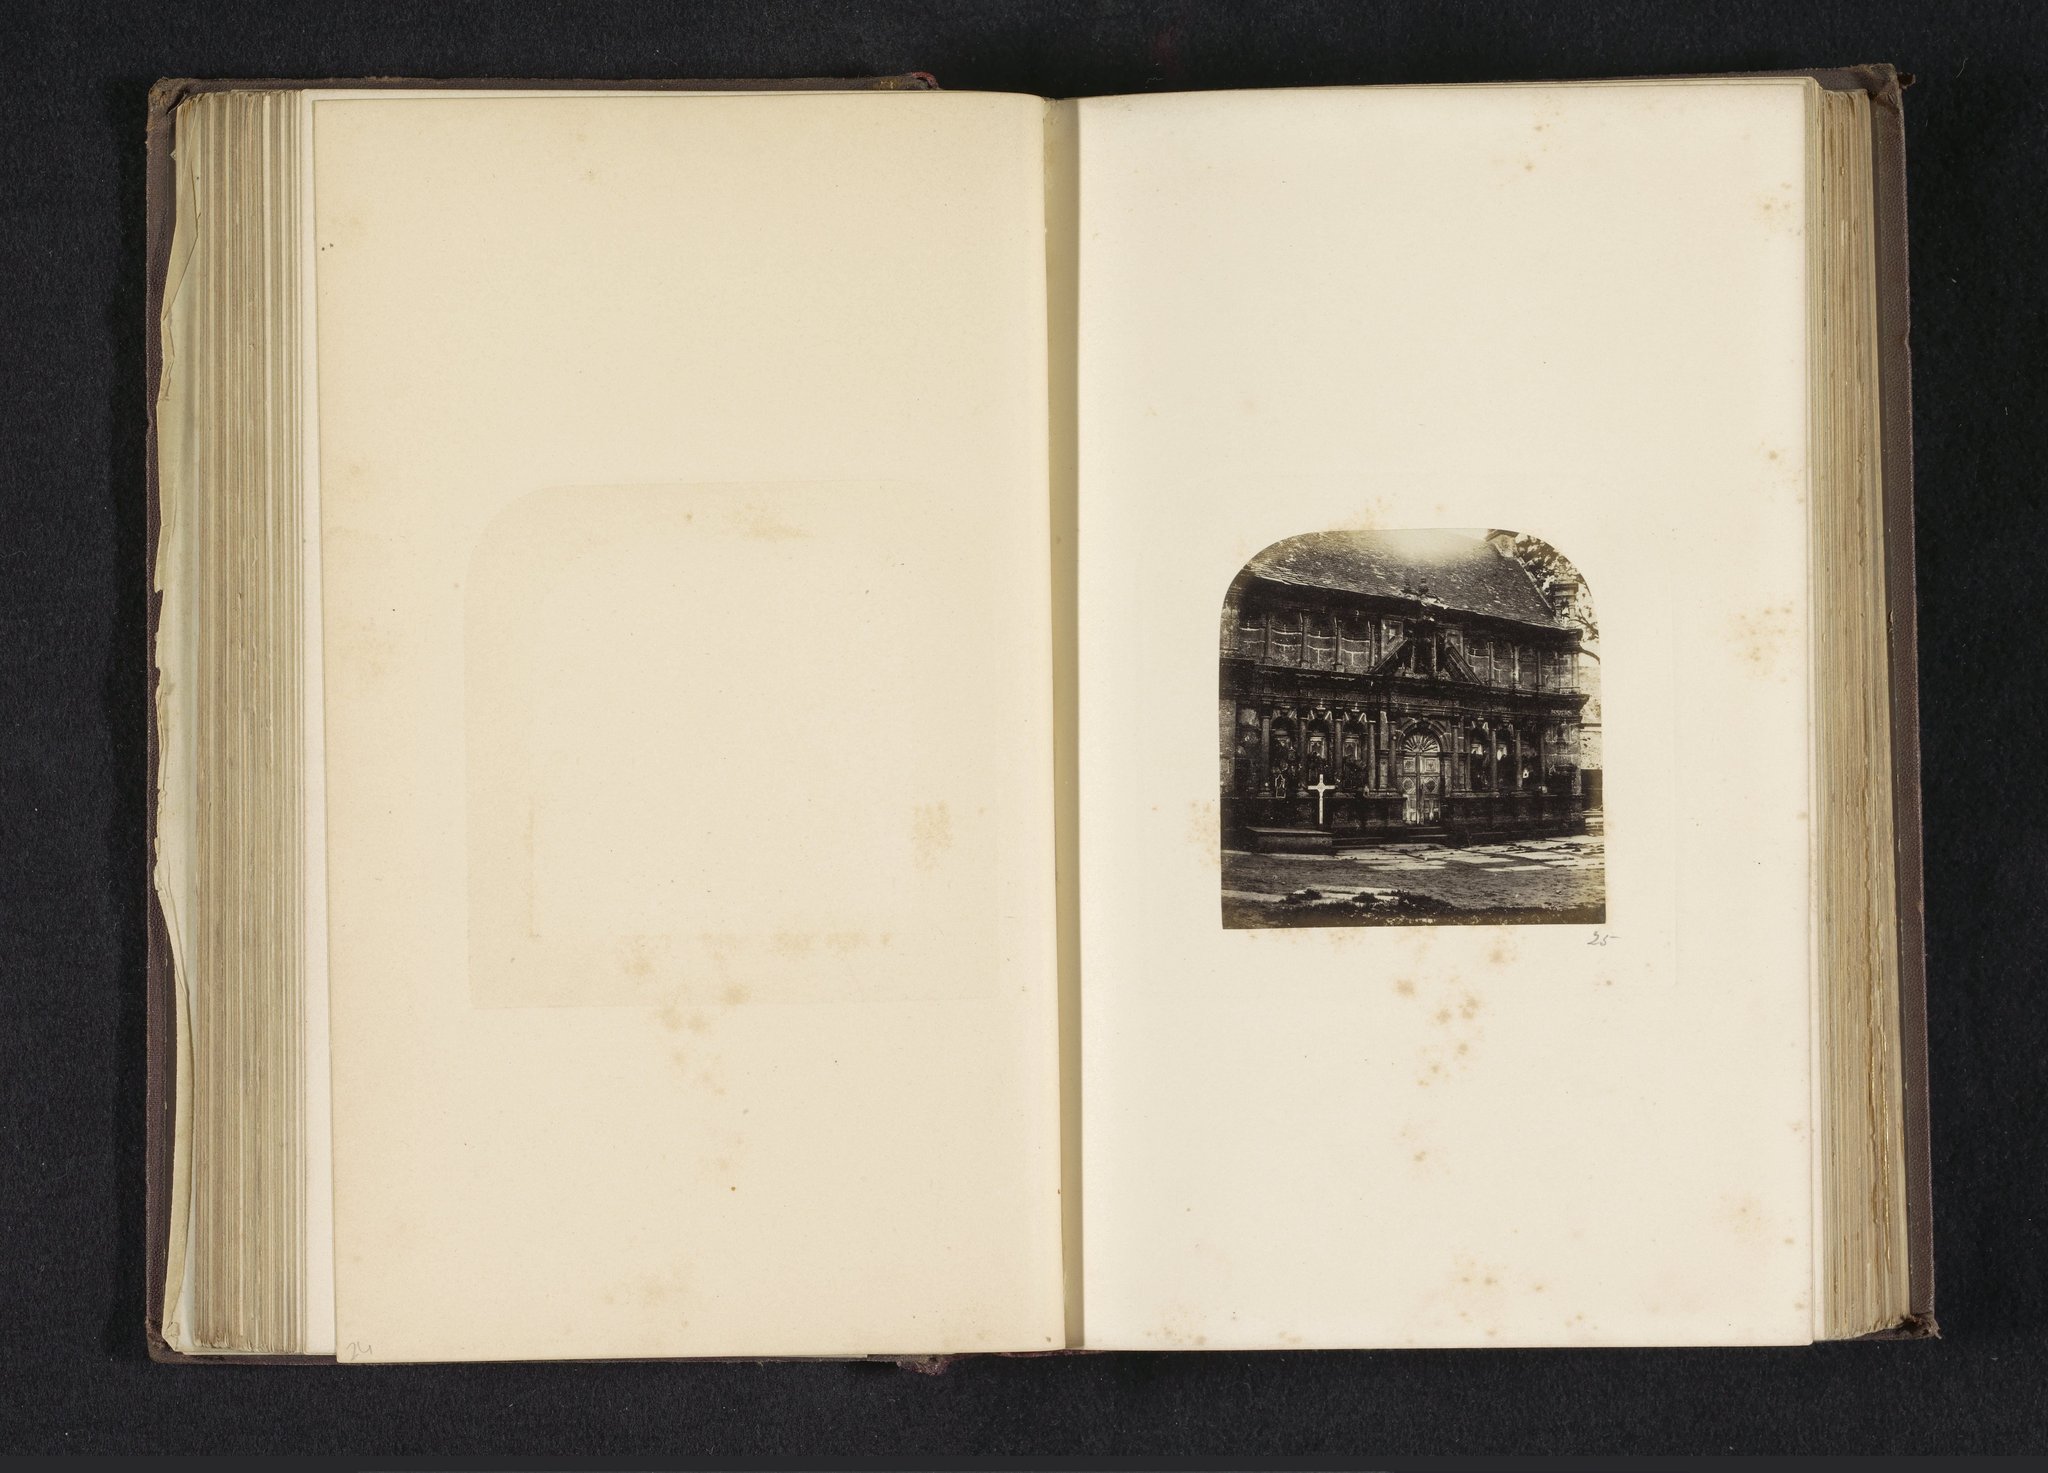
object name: page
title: Voorzijde van het knekelhuis in Saint-Thégonnec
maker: taylor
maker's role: fotograaf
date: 1850-1859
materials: photographic support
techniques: albumen print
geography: saint-thégonnec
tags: charnelhouse, ossuary, gate, entrance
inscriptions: number: ‘25’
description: Foto op tweede ongenummerde pagina na pagina 118.